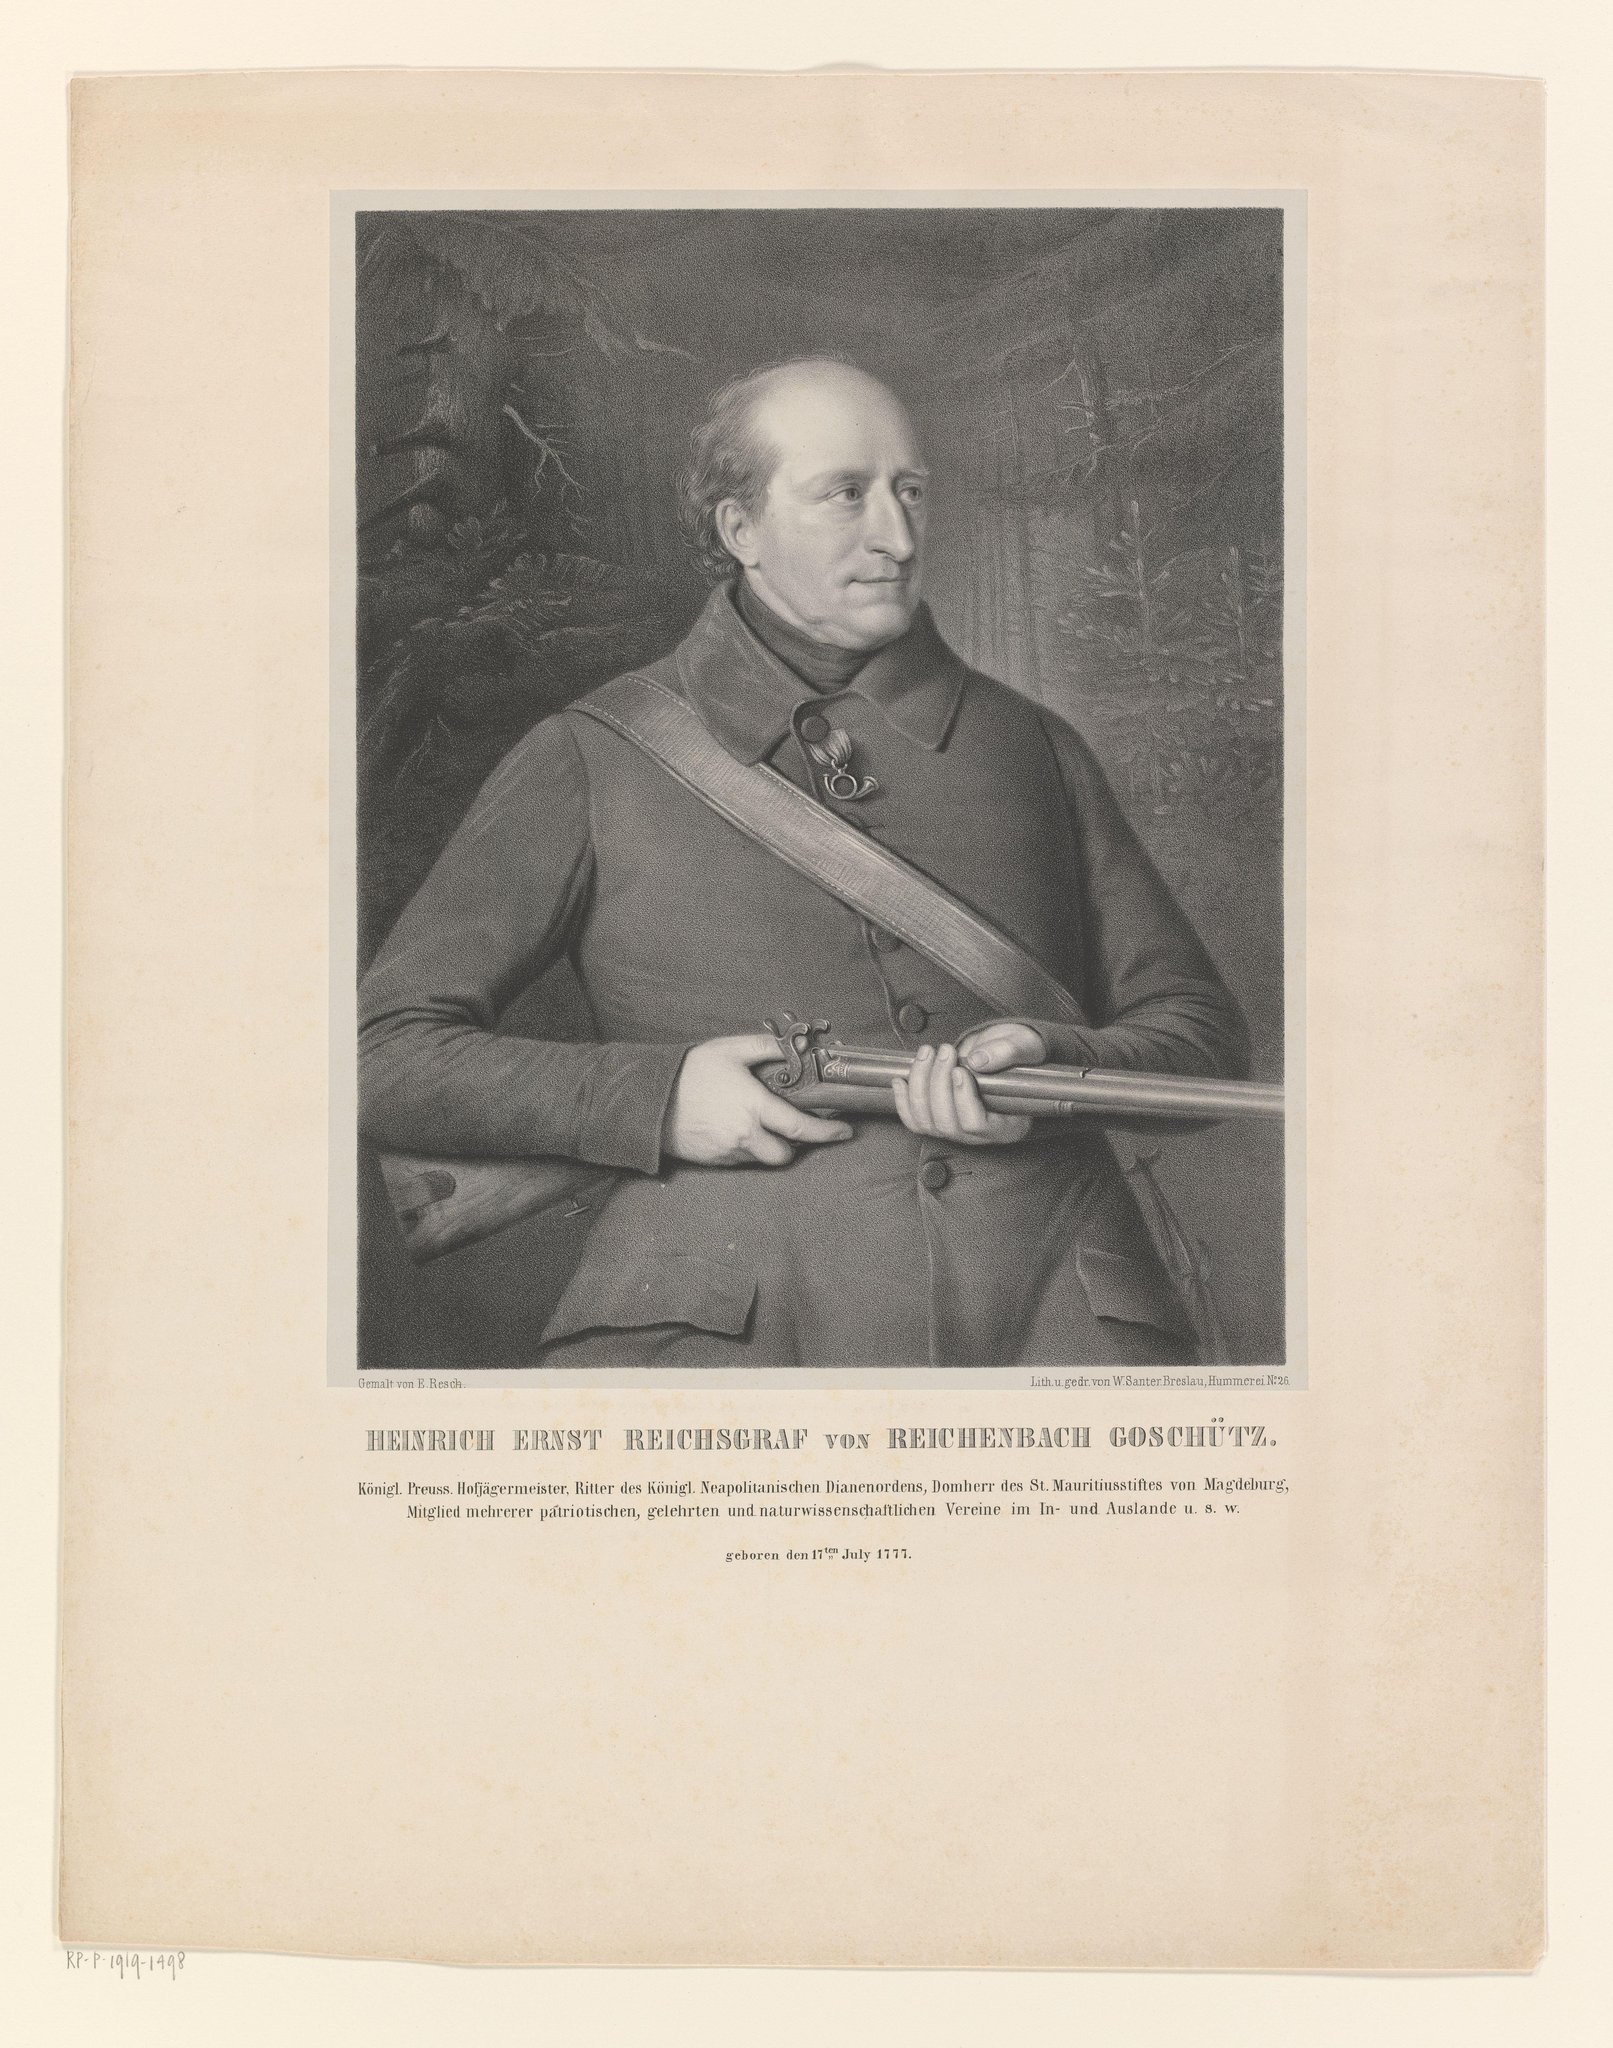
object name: print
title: Portret van Heinrich Ernst von Reichenbach Goschütz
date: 1820-1836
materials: paper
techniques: lithograph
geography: breslau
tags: adult man, historical persons, firearms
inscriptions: collector's mark: Lugt 2228